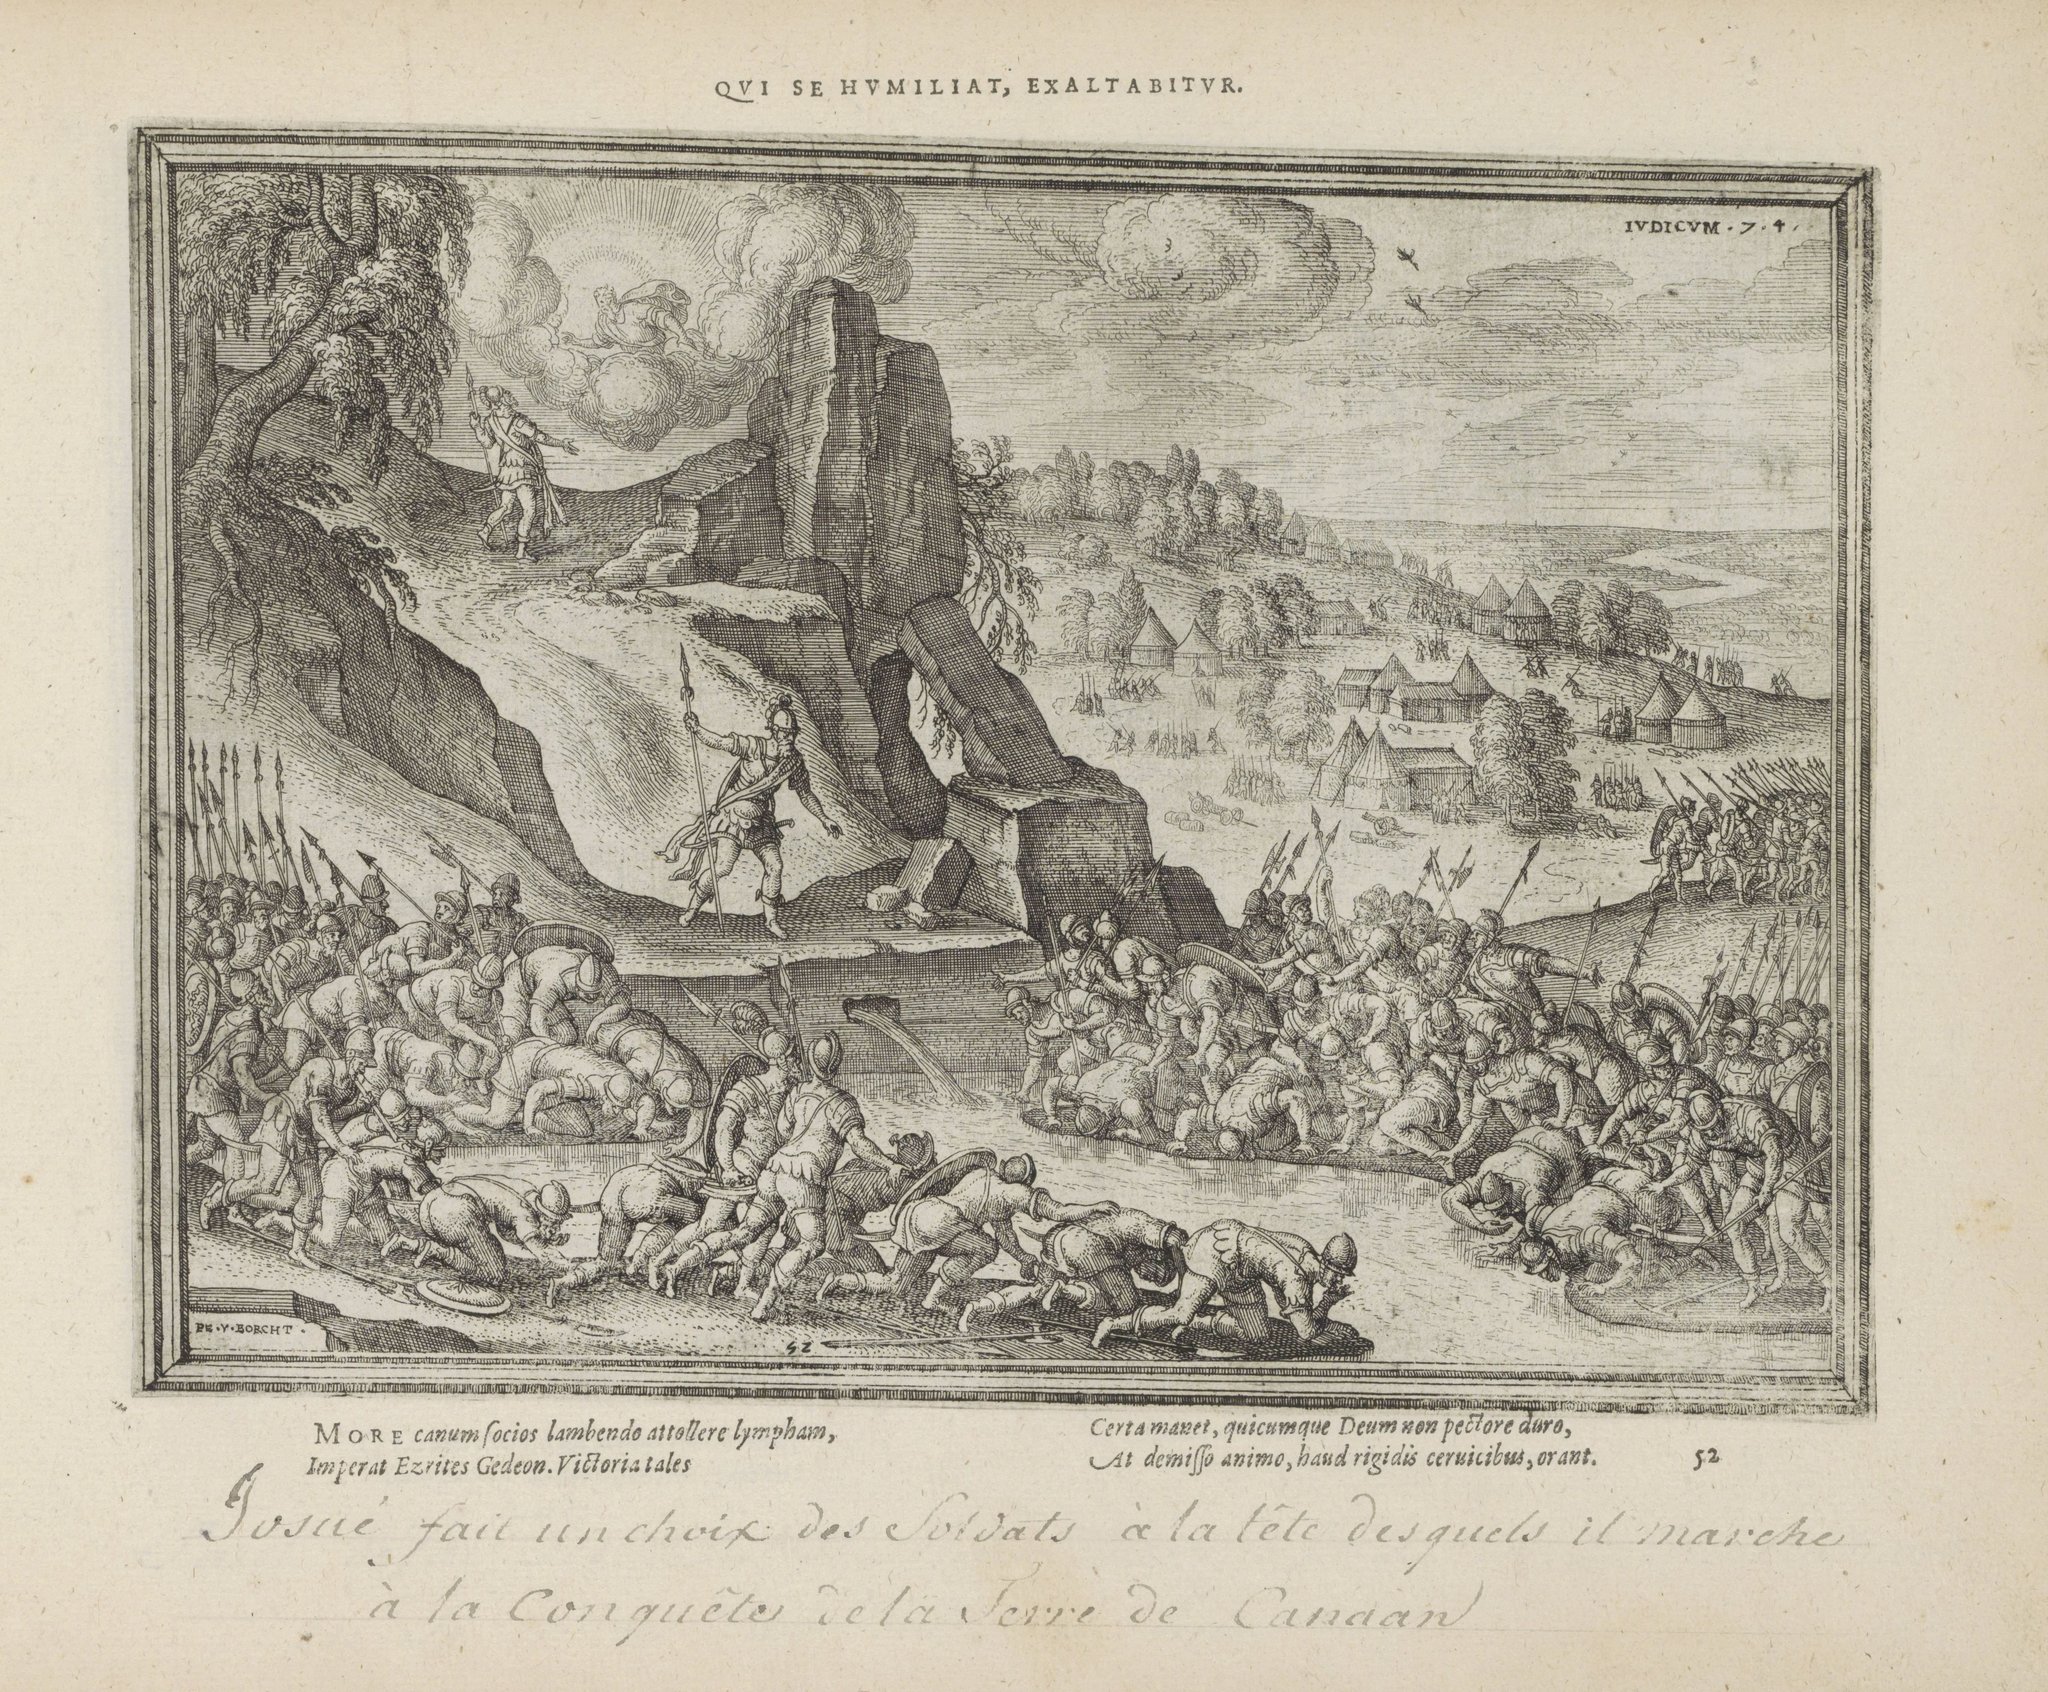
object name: album leaf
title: Emblemata Sacra è praecipuis utriusque testamenti historiis concinnata (Oude Testament)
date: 1582-1593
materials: paper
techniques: etching, letterpress printing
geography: antwerp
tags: those who lap water by putting their hand to their mouth are separated from those who kneel down to drink the water ~ selection of gideon's men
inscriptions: inscription: ‘Josué fait un choix des soldats à la tete desquels il marche à la Conguete de la Terre de Canaan’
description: Links op een berg verschijnt God aan Gideon. Daaronder beveelt Gideon zijn manschappen water te drinken. Driehonderd man likken het water op met hun tong en de overigen knielen om te drinken. De mannen die knielen om het water te drinken worden naar huis gestuurd (Recht. 7:4). Met een motto in het Latijn boven de voorstelling en een vierregelig onderschrift in het Latijn onder de prent. De prent maakt deel uit van een album.